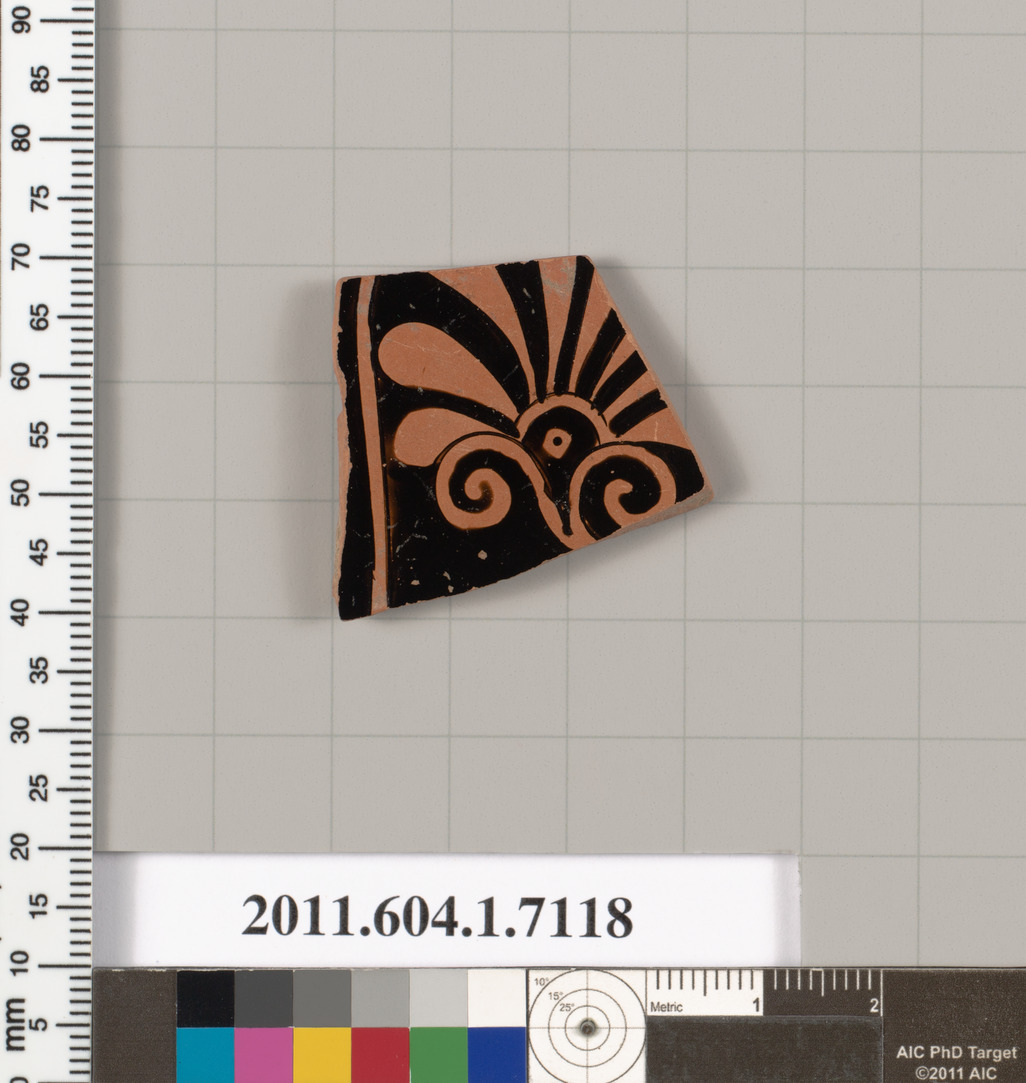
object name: kylix fragment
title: Terracotta fragment of a kylix (drinking cup)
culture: greek, attic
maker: douris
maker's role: artist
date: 500-480 BCE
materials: terracotta